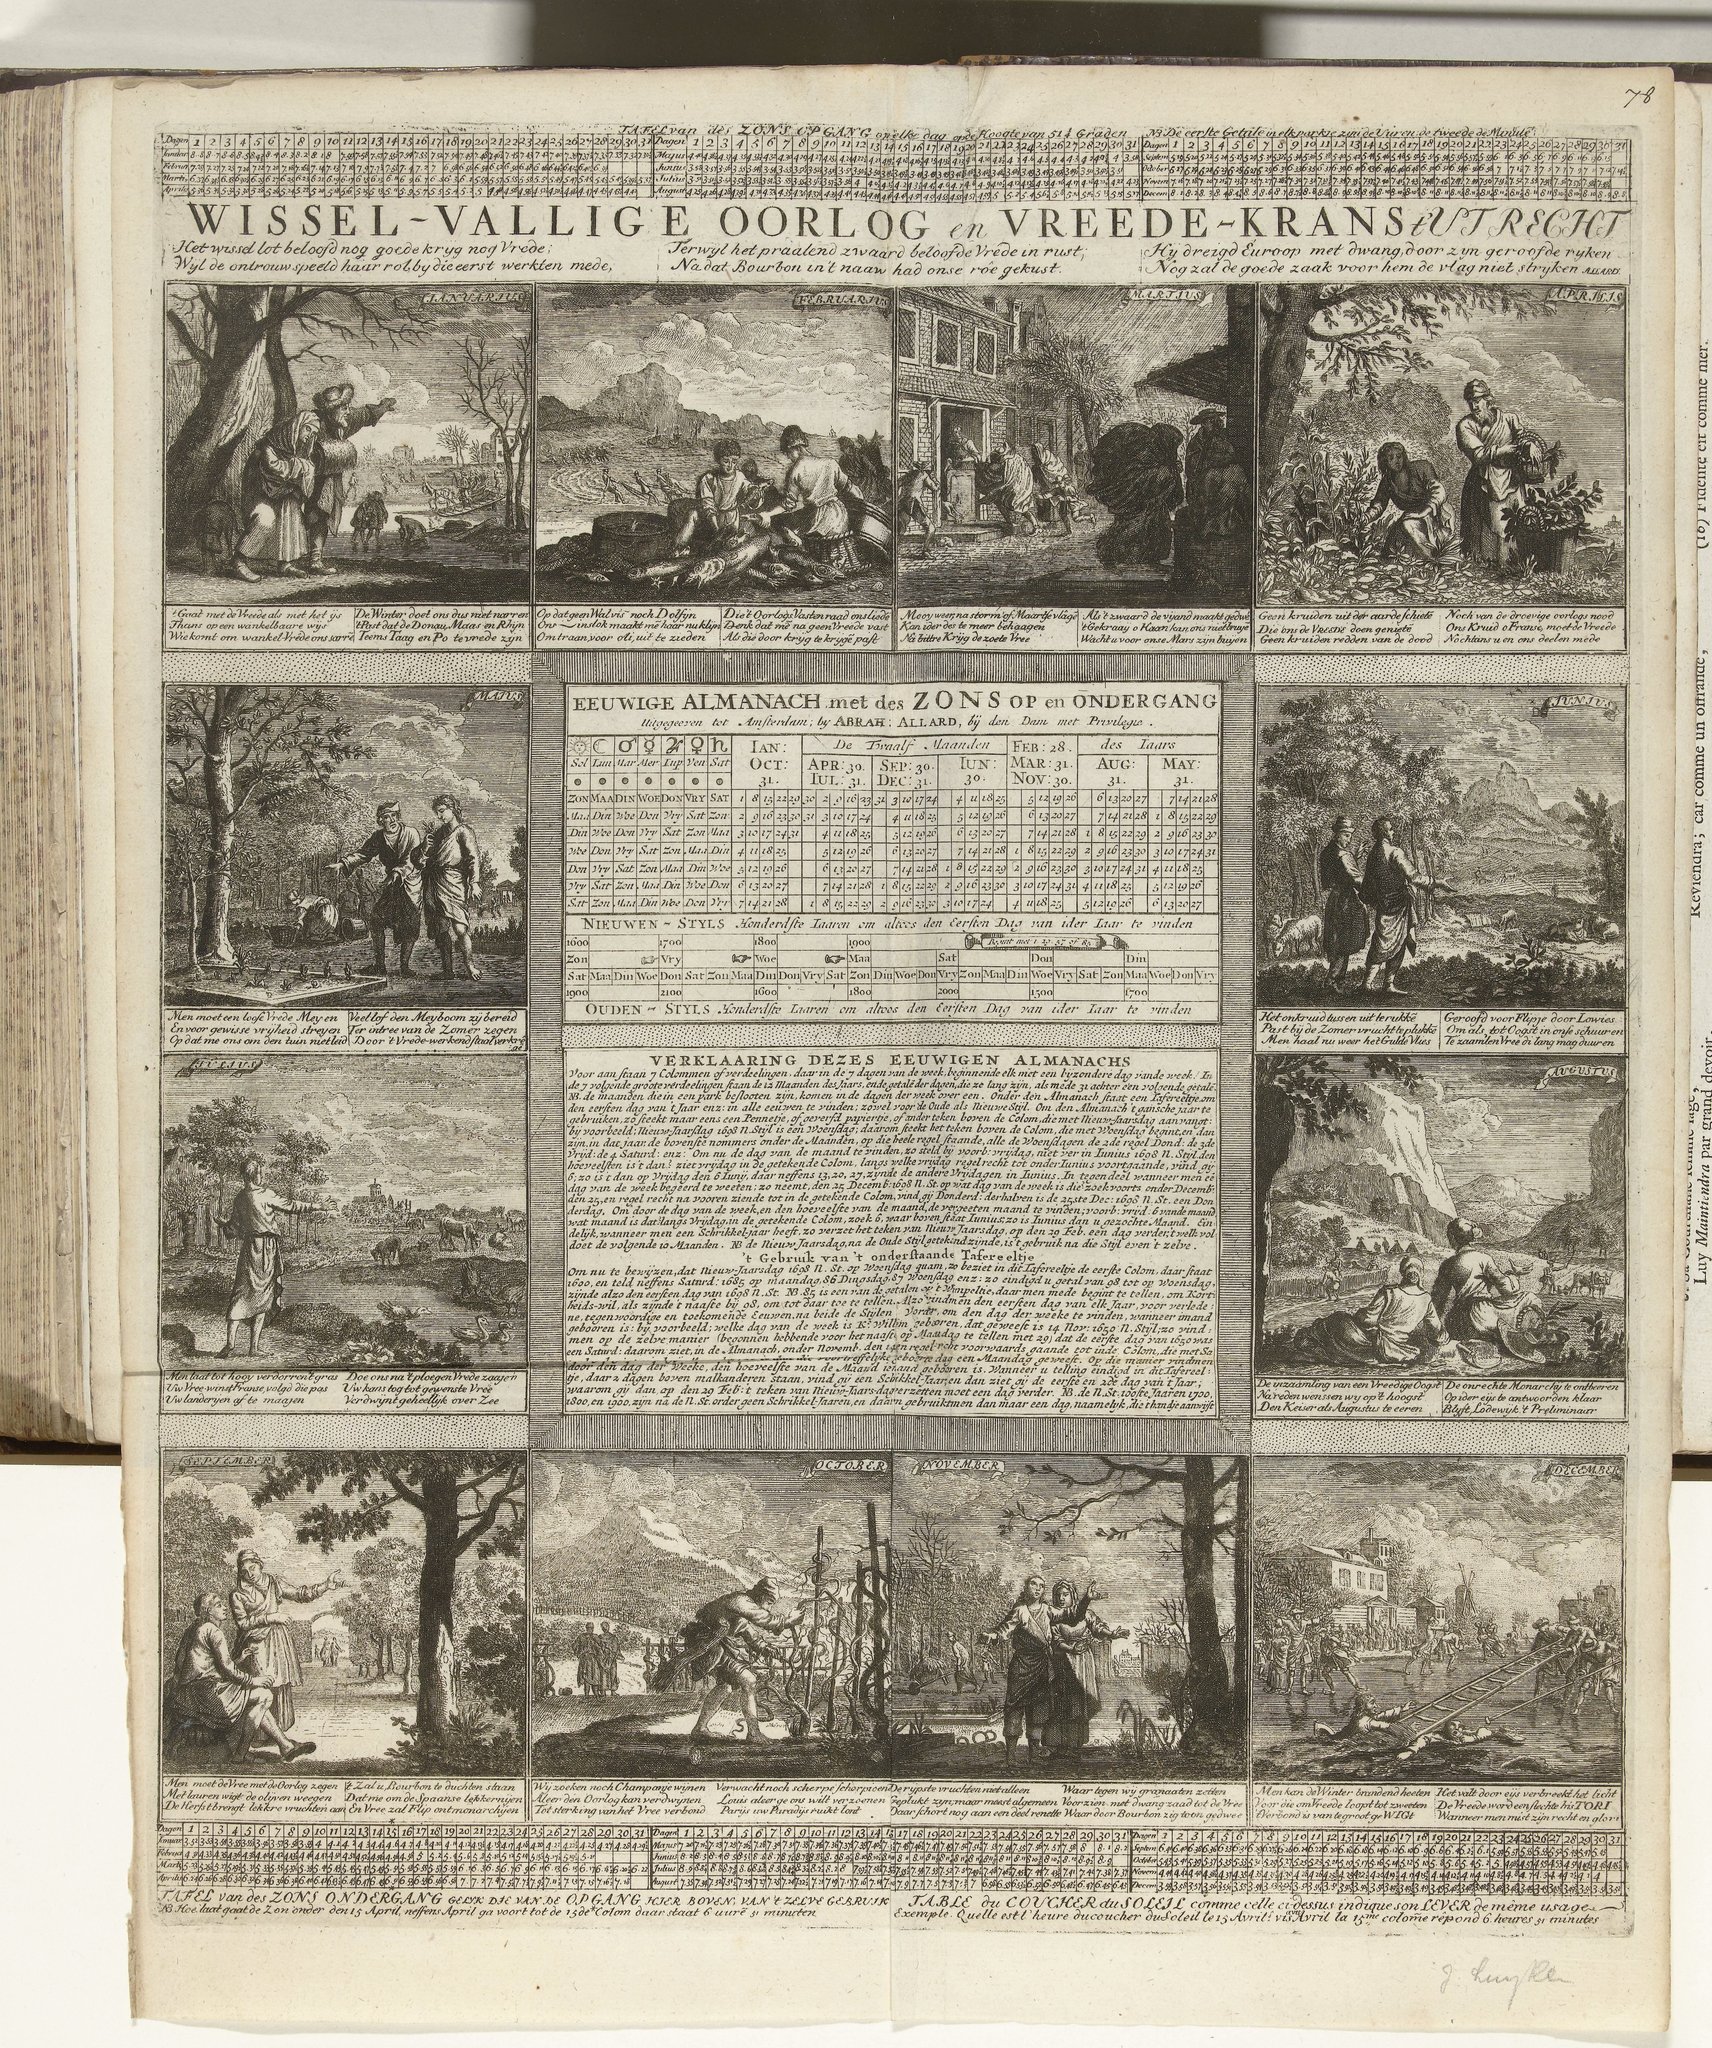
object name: print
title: Platen over de Vrede van Utrecht van 1713 / 't Lusthof van Momus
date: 1713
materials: paper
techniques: etching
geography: northern netherlands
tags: the twelve months represented by scenes showing human activities, usually in a landscape; so-called 'labours of the months'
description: Blad met een eeuwige almanak omringd door voorstellingen van de twaalf maanden van het jaar met verzen toepast op de politieke toestand in het jaar 1713. Onderdeel van een groep van 28 nieuwe en oude platen aangepast ter illustratie van de Vrede van Utrecht in 1713. Onderdeel van het prentwerk uitgegeven onder de verzameltitel 't Lust-Hof van Momus met de gebundelde series van spotprenten tijdens de jaren 1701-1713 van de Spaanse Successieoorlog.